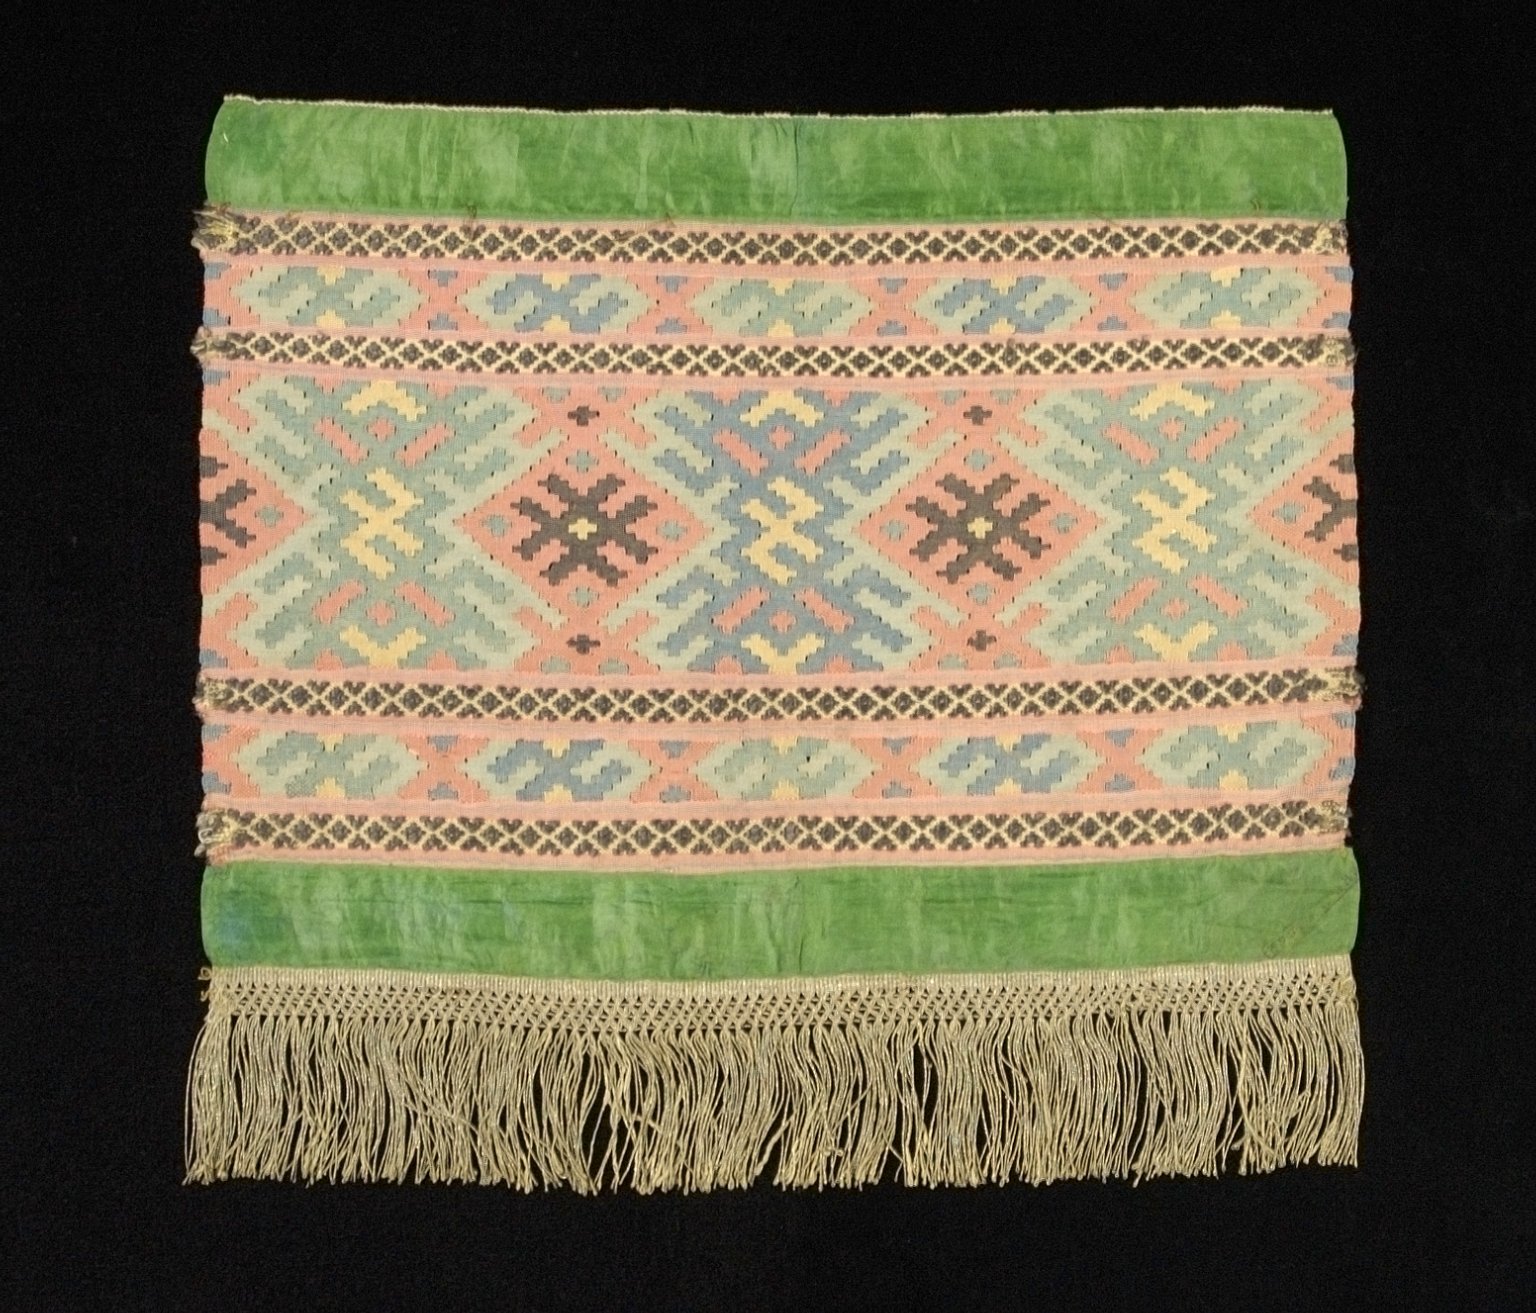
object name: textile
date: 1840-1870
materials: silk